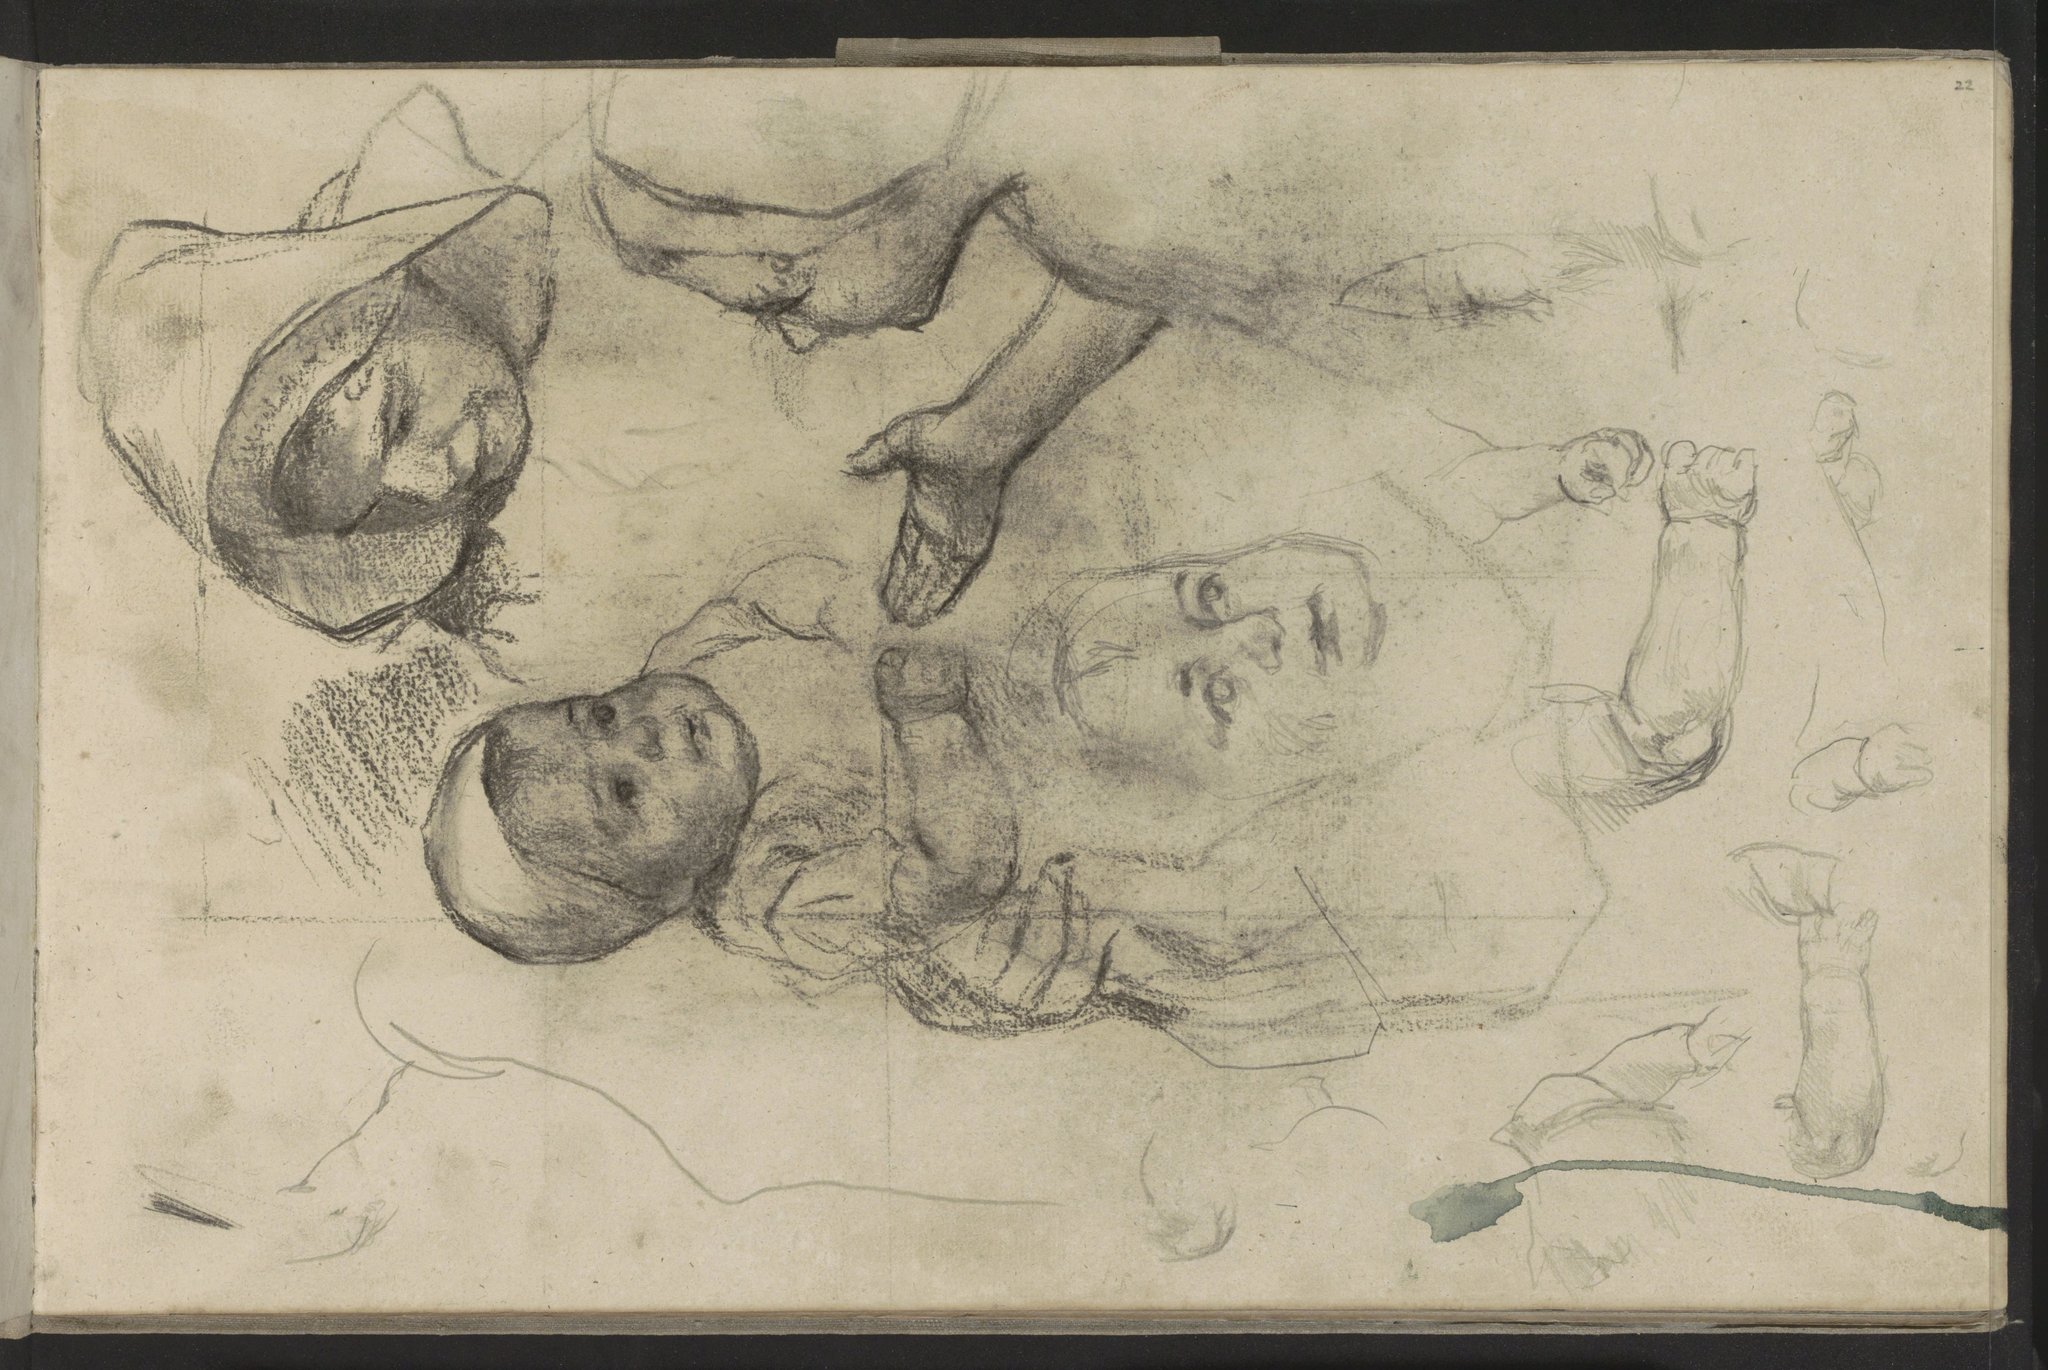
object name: sketchbook leaf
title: Studieblad met een baby, meisjeskoppen en armen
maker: albert neuhuys (1844-1914)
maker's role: draughtsman, painter, print maker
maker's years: 1844-1914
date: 1854-1914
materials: charcoal, paper, pencil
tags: head (human), arms, head-gear: cap (+ women's clothes), girl (child between toddler and youth), infant, baby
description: Blad 22 recto uit een schetsboek met 51 bladen.